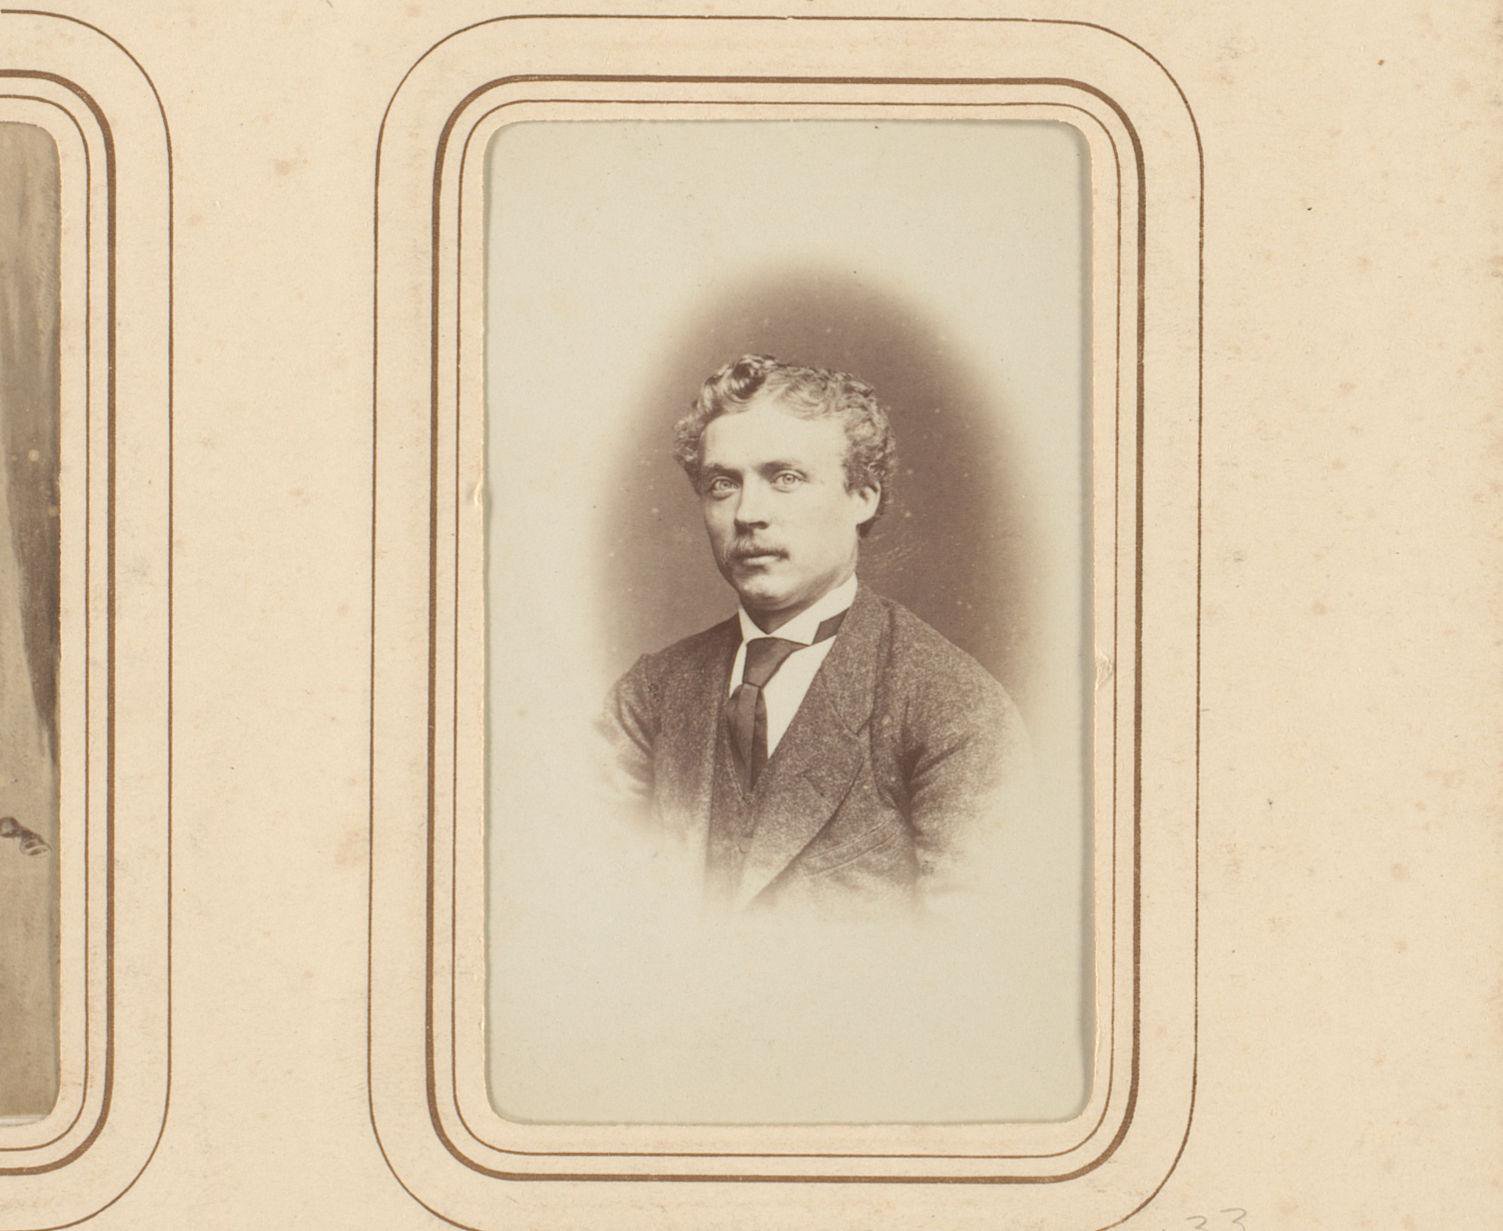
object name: album leaf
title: Portret van een man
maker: christaan marcussen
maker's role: fotograaf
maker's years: 1822-1878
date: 1865-1880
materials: cardboard, photographic support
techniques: albumen print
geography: utrecht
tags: adult man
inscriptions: inscription: ‘C. Marcussen/ Kunstschilder en Photograaf/ Utrecht/ Hamburgerstraat naast het Geregtshof.’